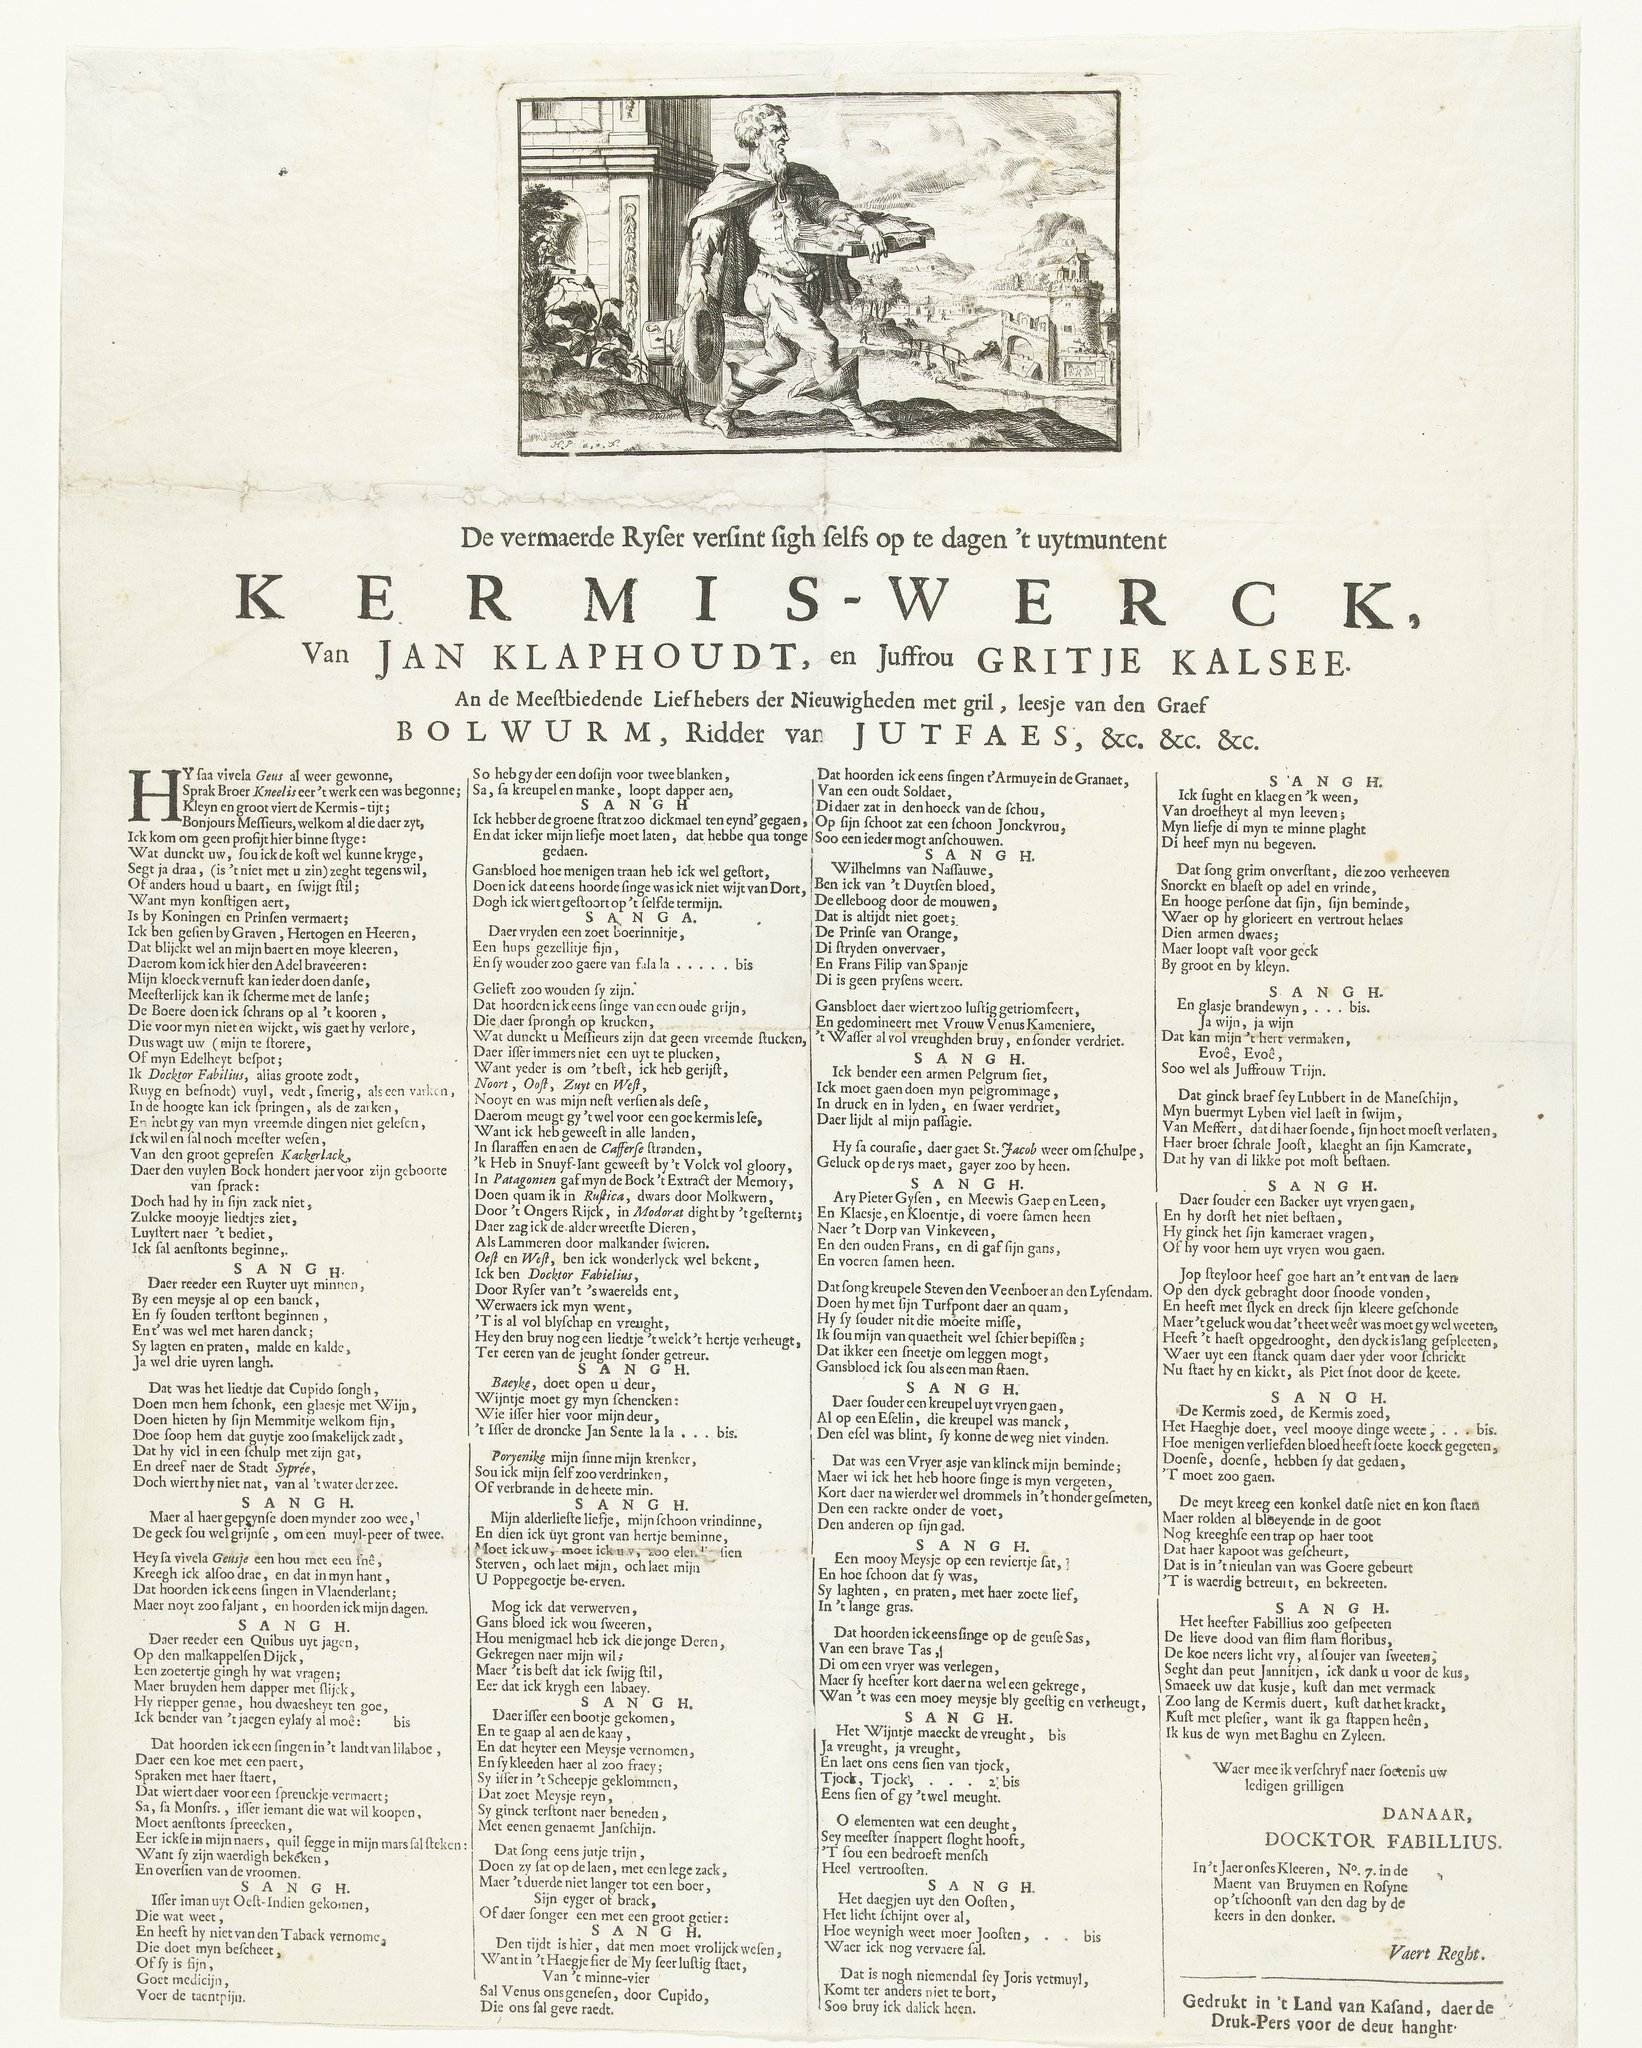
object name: fair print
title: De vermaerde Ryser versint sigh selfs op te dagen 't uytmuntent Kermis-Werck, van Jan Klaphoudt, en Juffrou Gritje Kalsee"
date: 1690-1710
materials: paper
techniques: etching, letterpress printing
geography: northern netherlands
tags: print, e.g.: engraving, etching, lithograph, pedlar, pamphlet ~ printed matter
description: Kermisprent met een voorstelling van een pamflet- of prentverkoper. Gedrukt op het blad onder de plaat een lang spotvers over vrijen, drinken en zingen op de kermis, in het Nederlands in 4 kolommen.